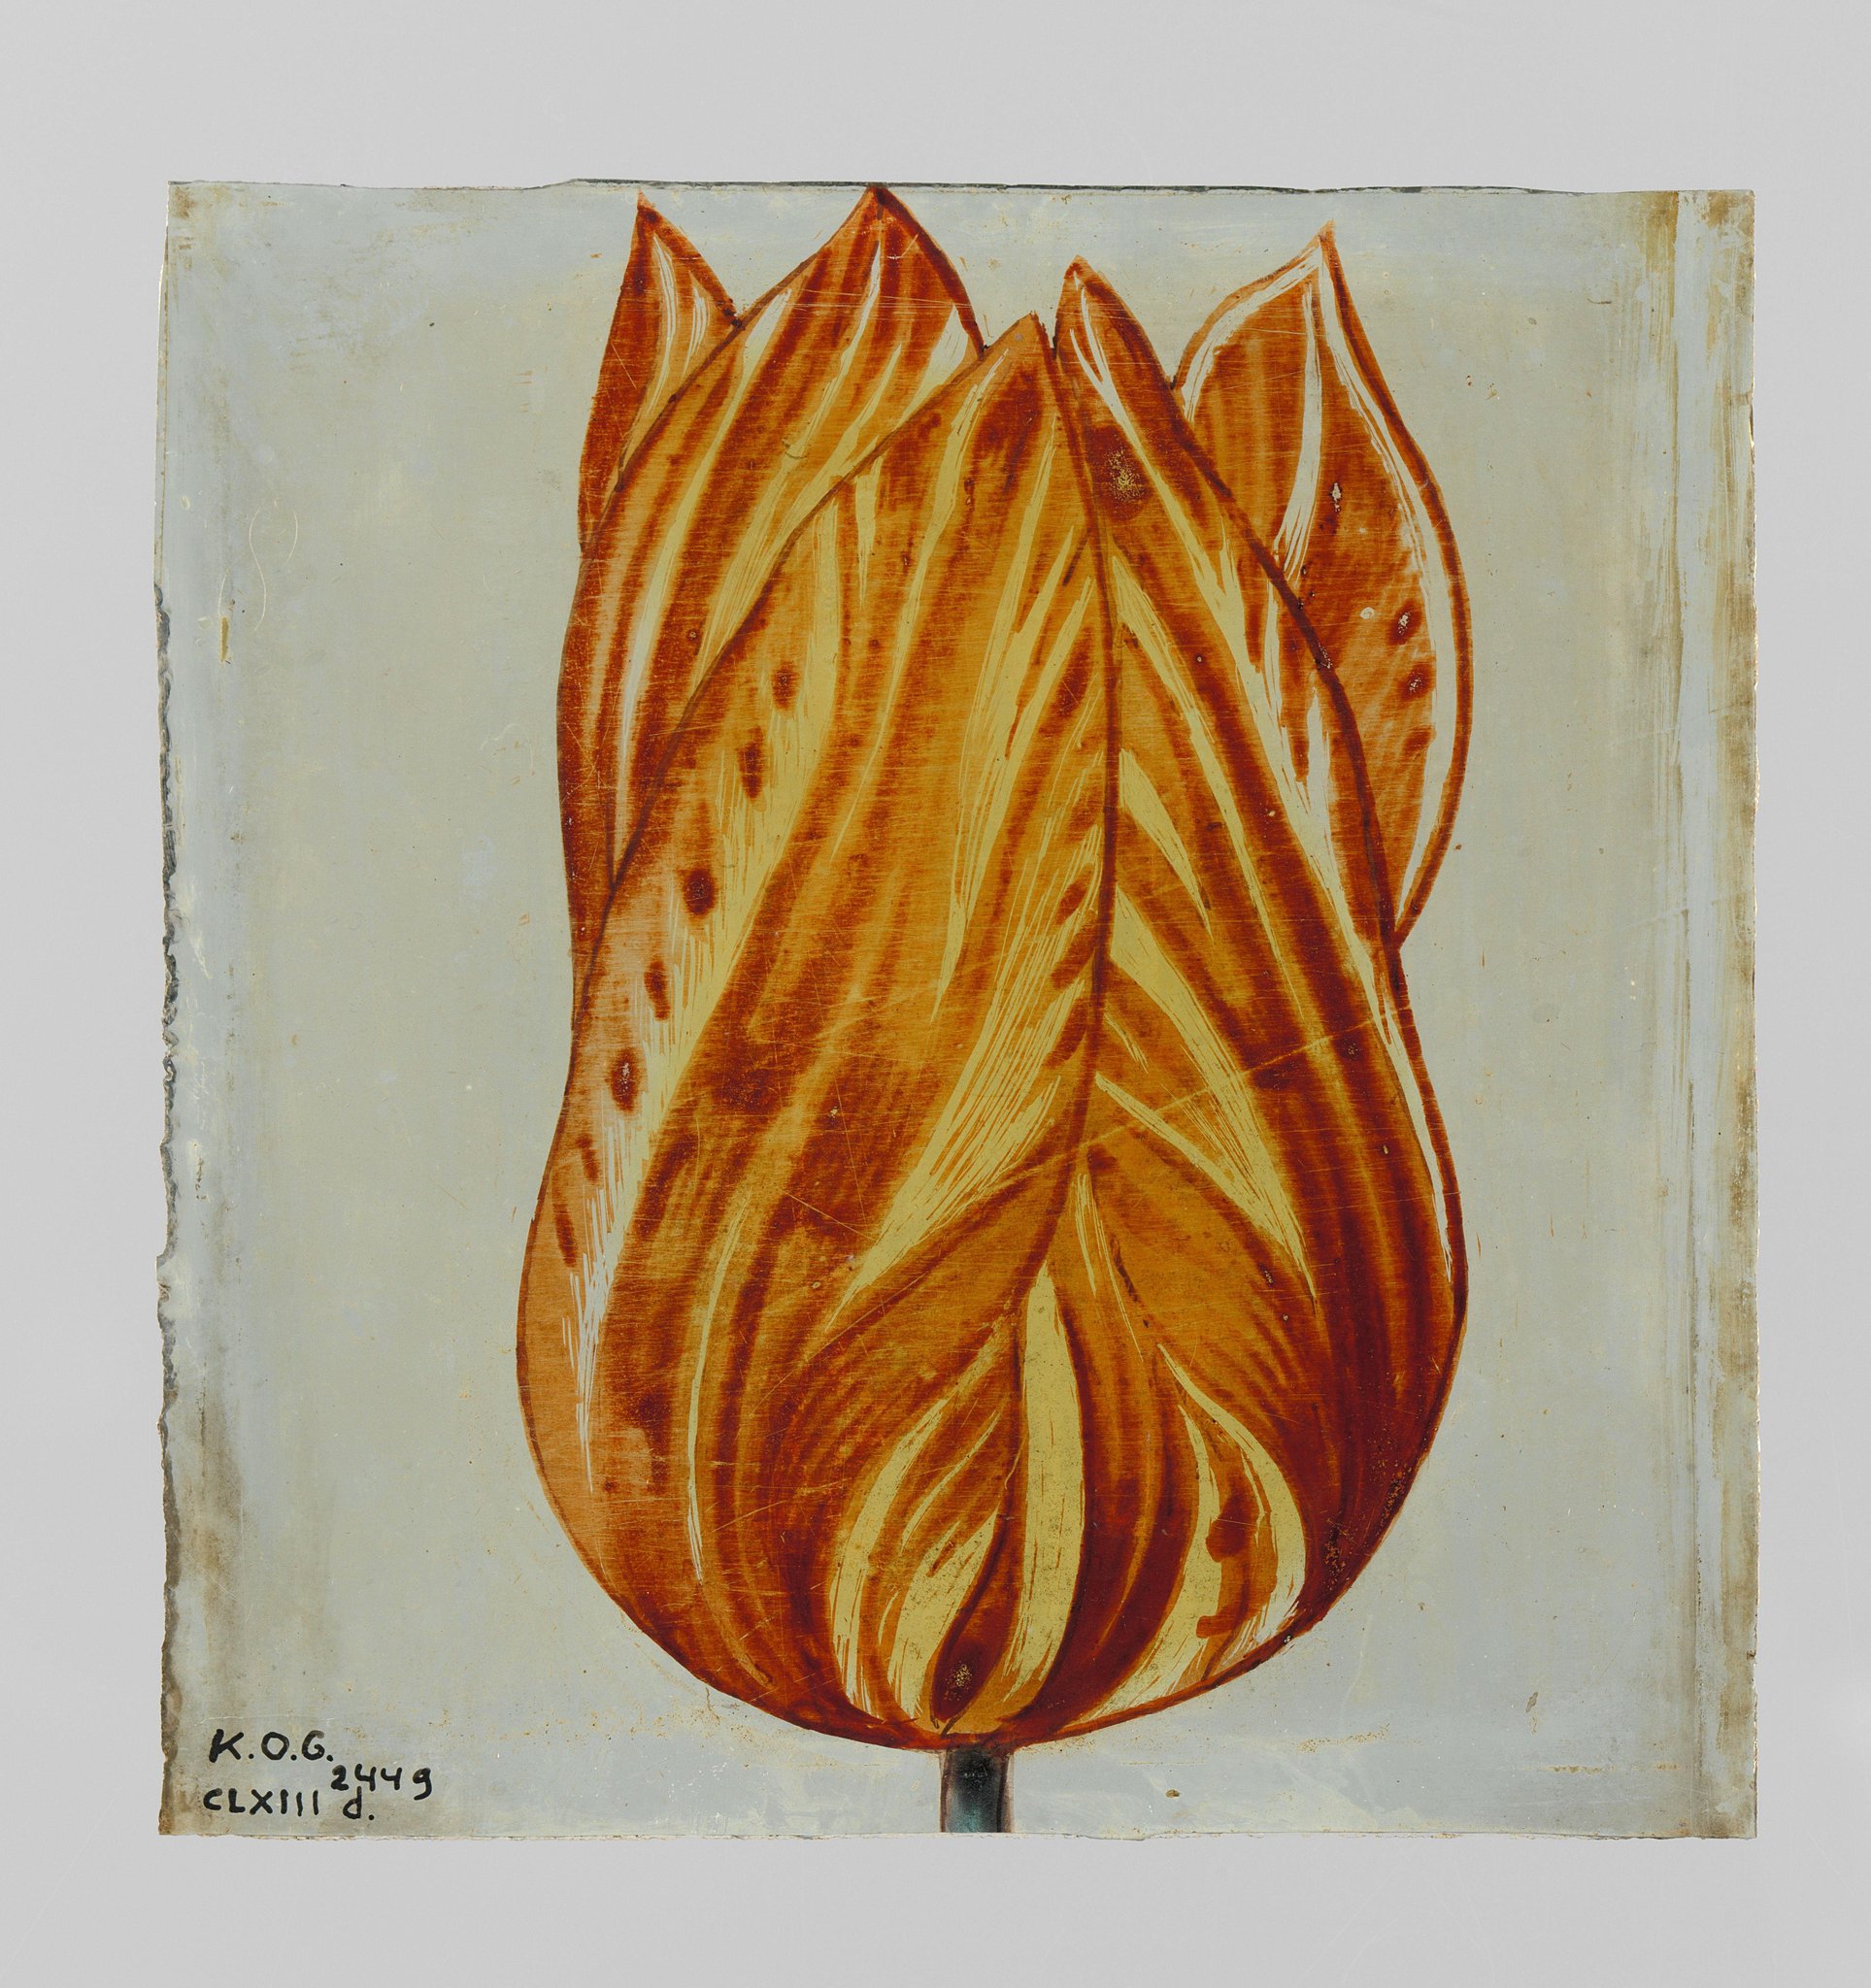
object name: light window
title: Ruit met tulp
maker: Anonymous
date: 1550-1600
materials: glass, lead, pigment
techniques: leading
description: Ruitje met emailschildering van een tulp in overwegend geel en rood. Opmerking: Onderdeel van de groep BK-CLXIII-a t/m r.